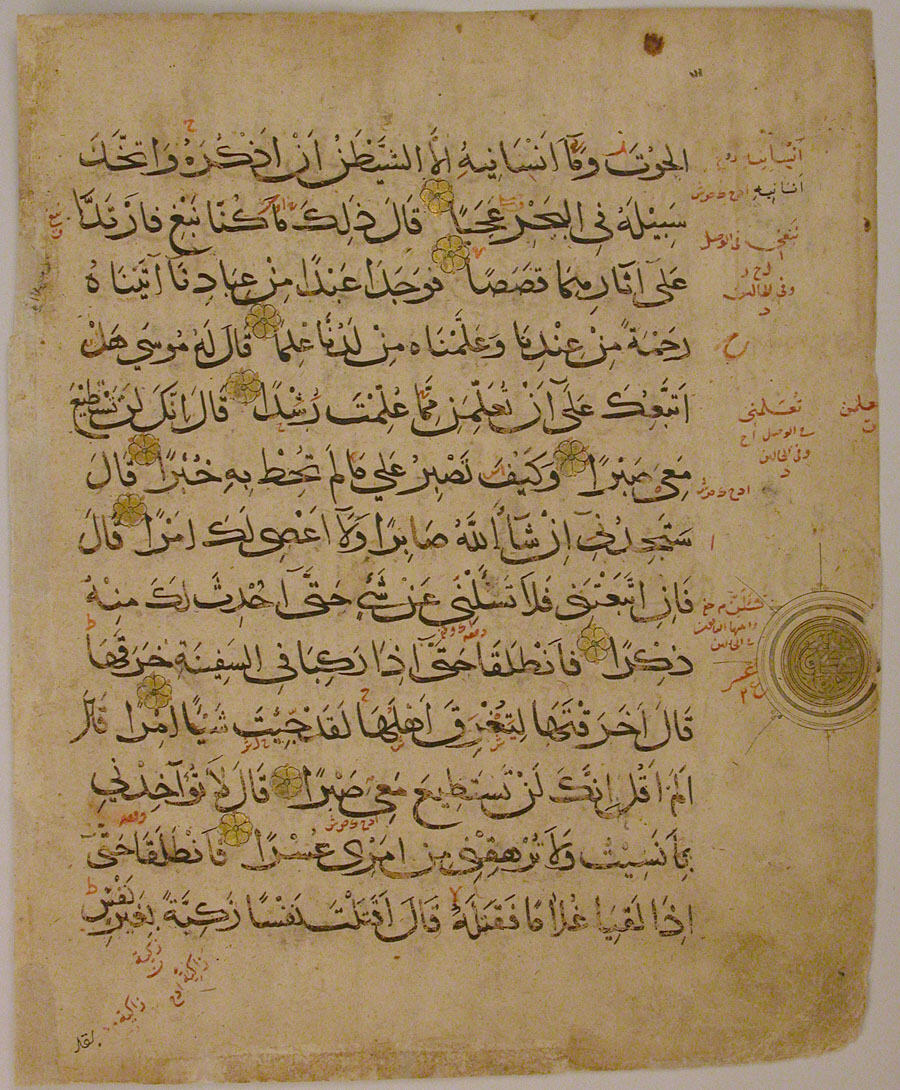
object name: folio from a non illustrated manuscript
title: Folios from a Qur'an Manuscript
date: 1301-1400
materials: gold, ink, paper, watercolor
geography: egypt or syria